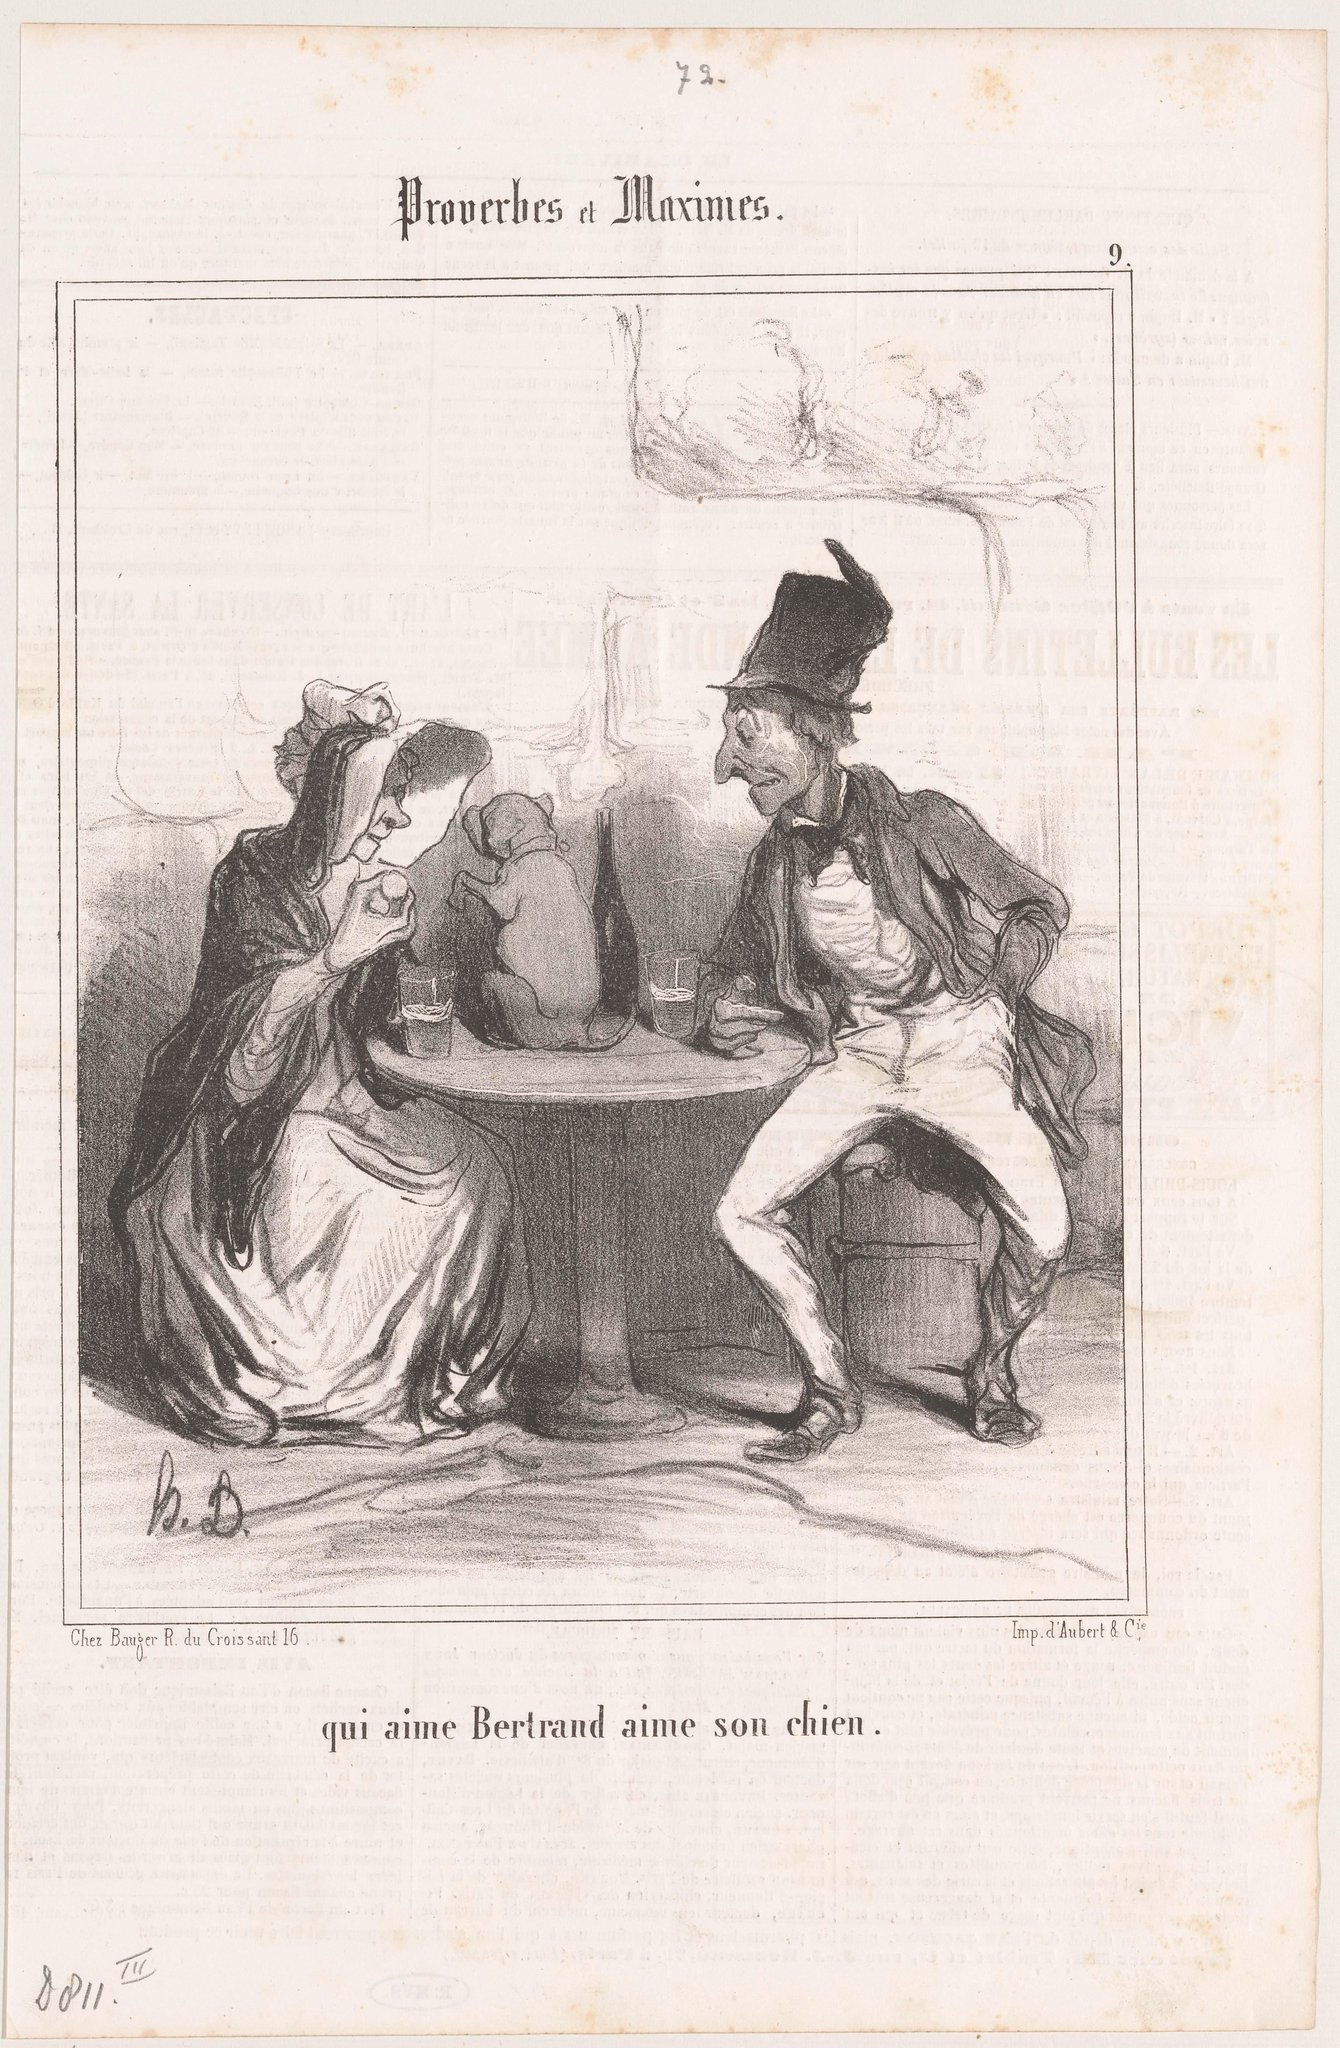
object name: cartoon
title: Qui aime Bertrand aime son chien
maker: honoré daumier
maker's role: draughtsman, painter, print maker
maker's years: 1808-1879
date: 1840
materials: paper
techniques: letterpress printing, lithograph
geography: paris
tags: caricatures (human types), inn, coffee-house, public house, etc., training of dogs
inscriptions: collector's mark: Lugt 2228a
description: Prent mogelijk uit: Le Charivari, 22 juli 1840.